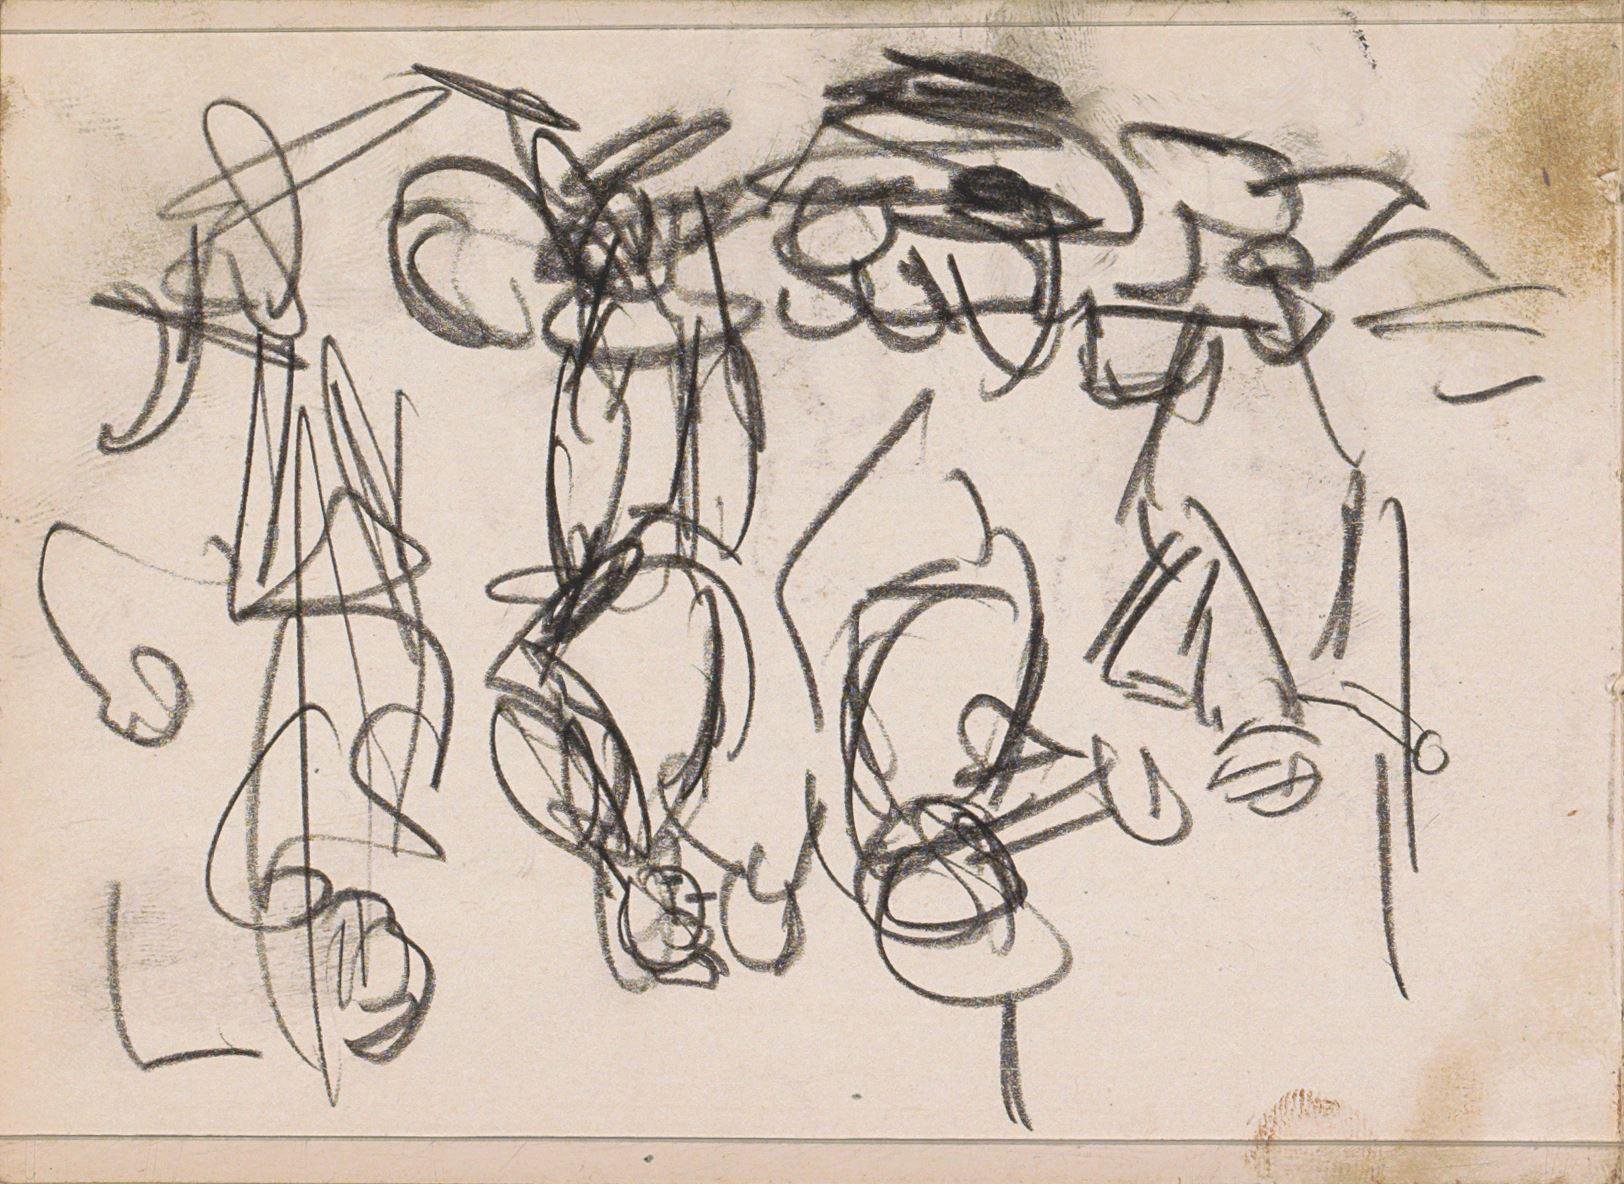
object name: sketchbook leaf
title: Staande figuren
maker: isaac israels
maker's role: draughtsman, painter, print maker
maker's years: 1865-1934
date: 1875-1934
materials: chalk, paper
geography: paris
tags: the (nude) human figure; 'corpo humano' (ripa) (+ standing)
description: Pagina 39 uit schetsboek XLV met 85 pagina's.